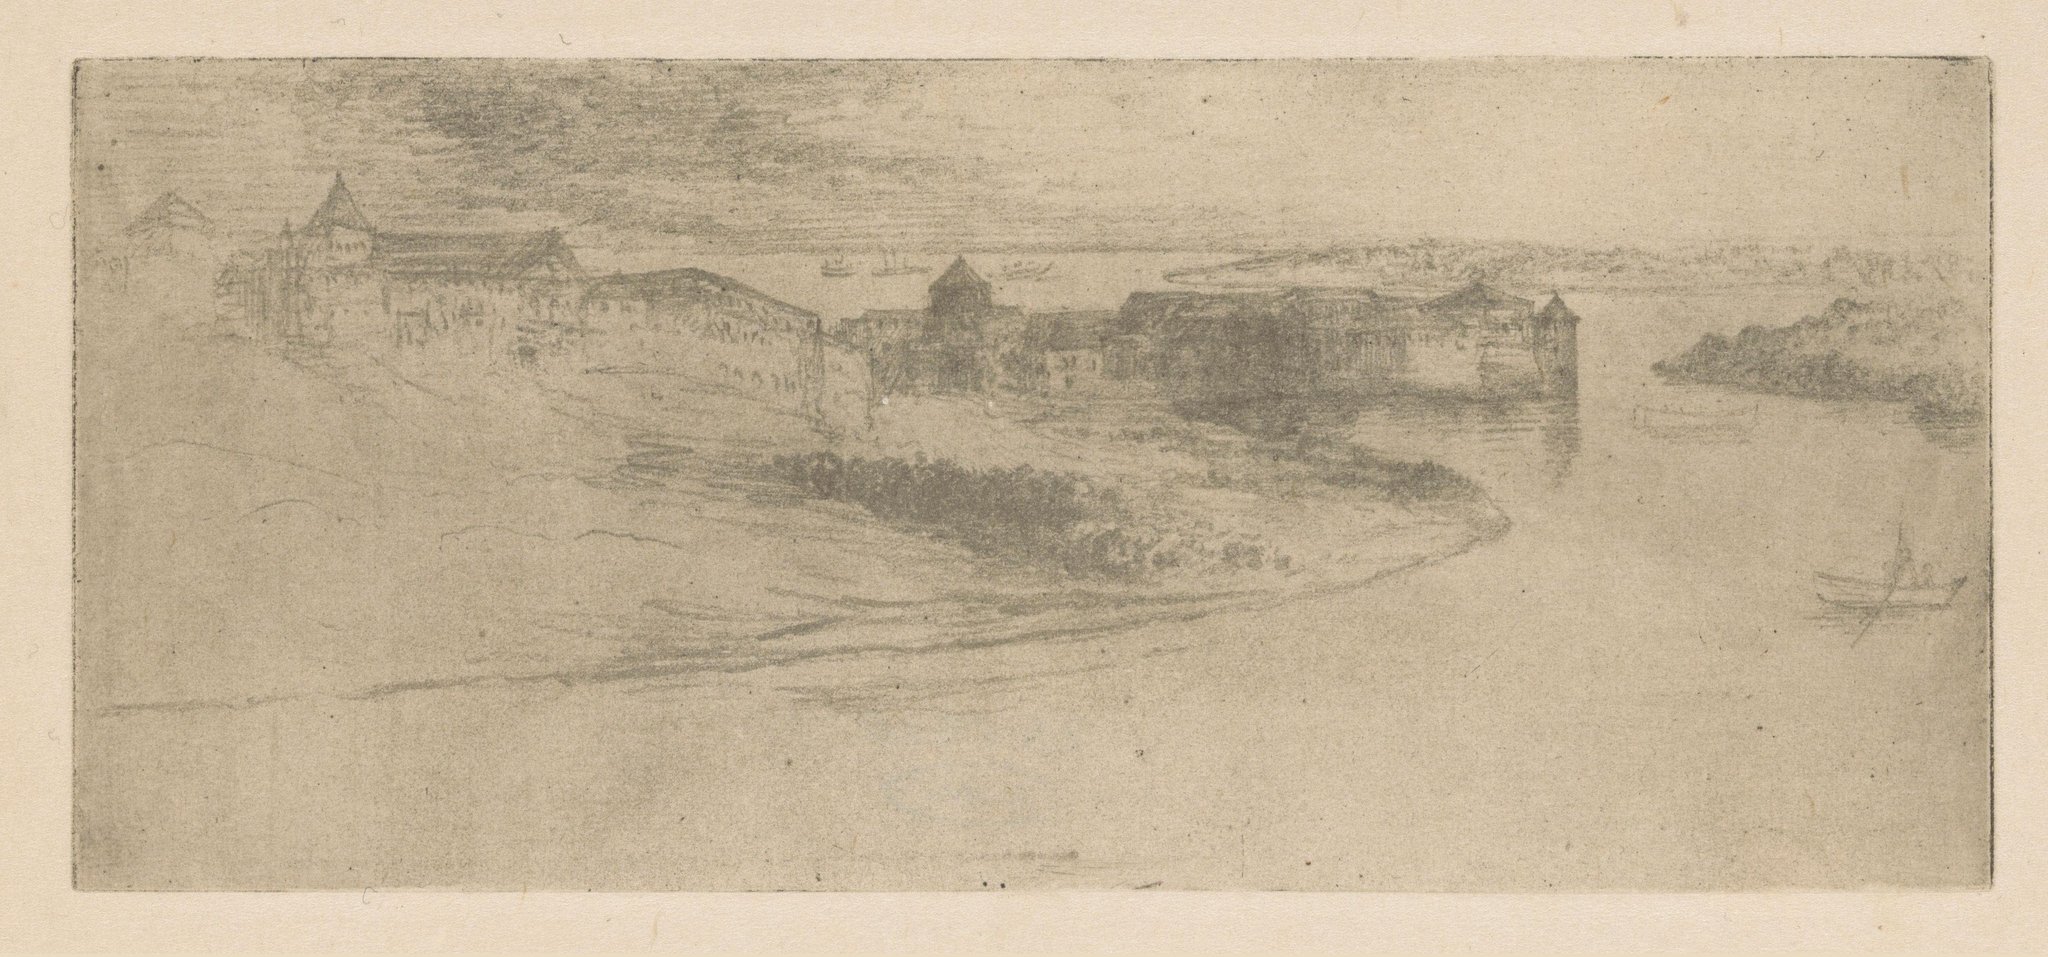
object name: print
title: Rivierlandschap met vestingstad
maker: marius holleman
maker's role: draughtsman, print maker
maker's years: 1878-1926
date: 1904-1926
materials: paper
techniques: etching, intaglio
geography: groningen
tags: river, prospect of city, town panorama, silhouette of city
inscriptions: collector's mark: Lugt 2228